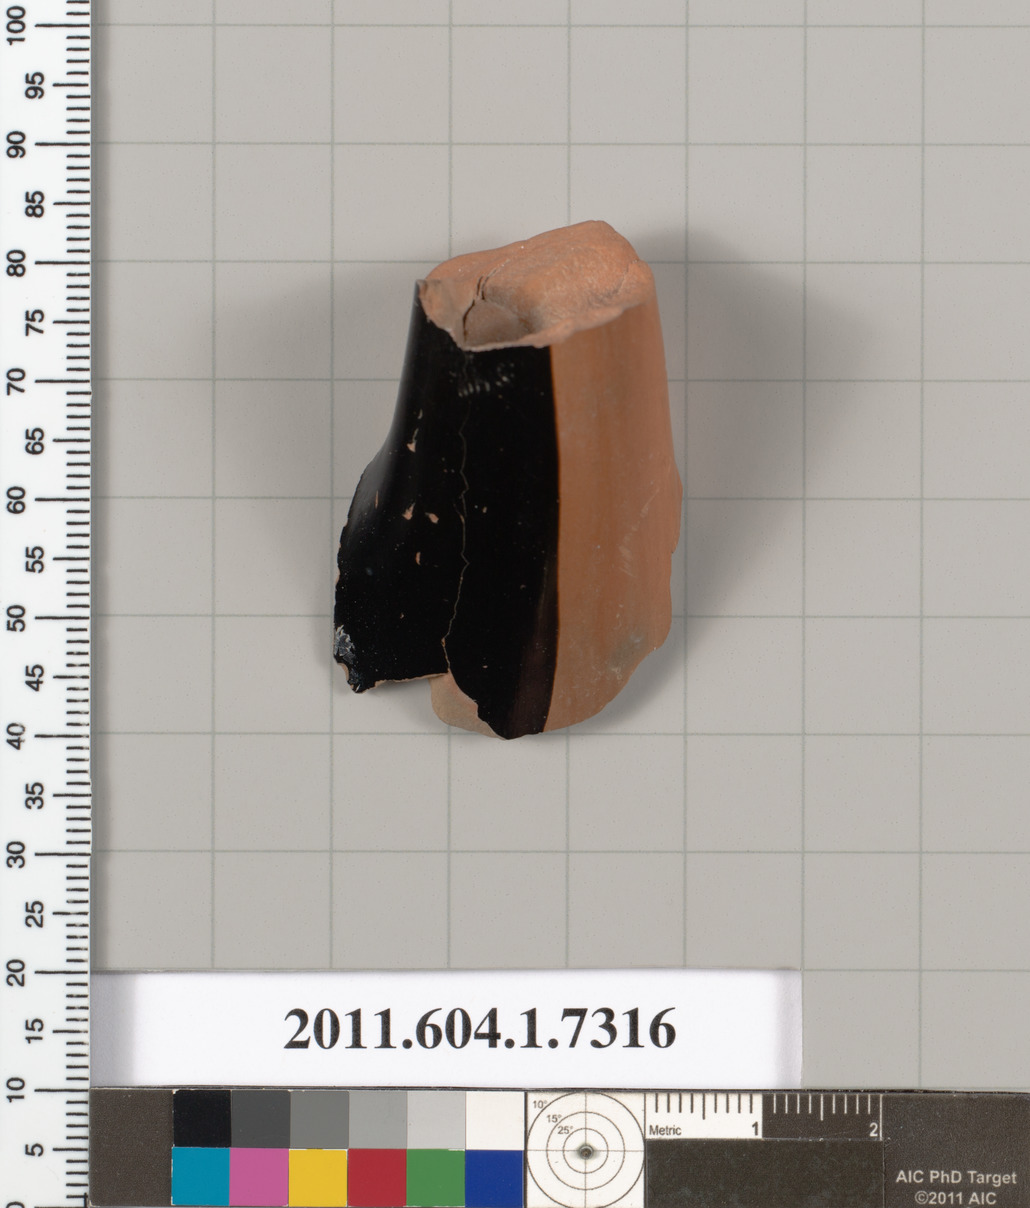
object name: kylix fragment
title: Terracotta fragment of a kylix (drinking cup)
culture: greek, attic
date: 500-480 BCE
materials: terracotta